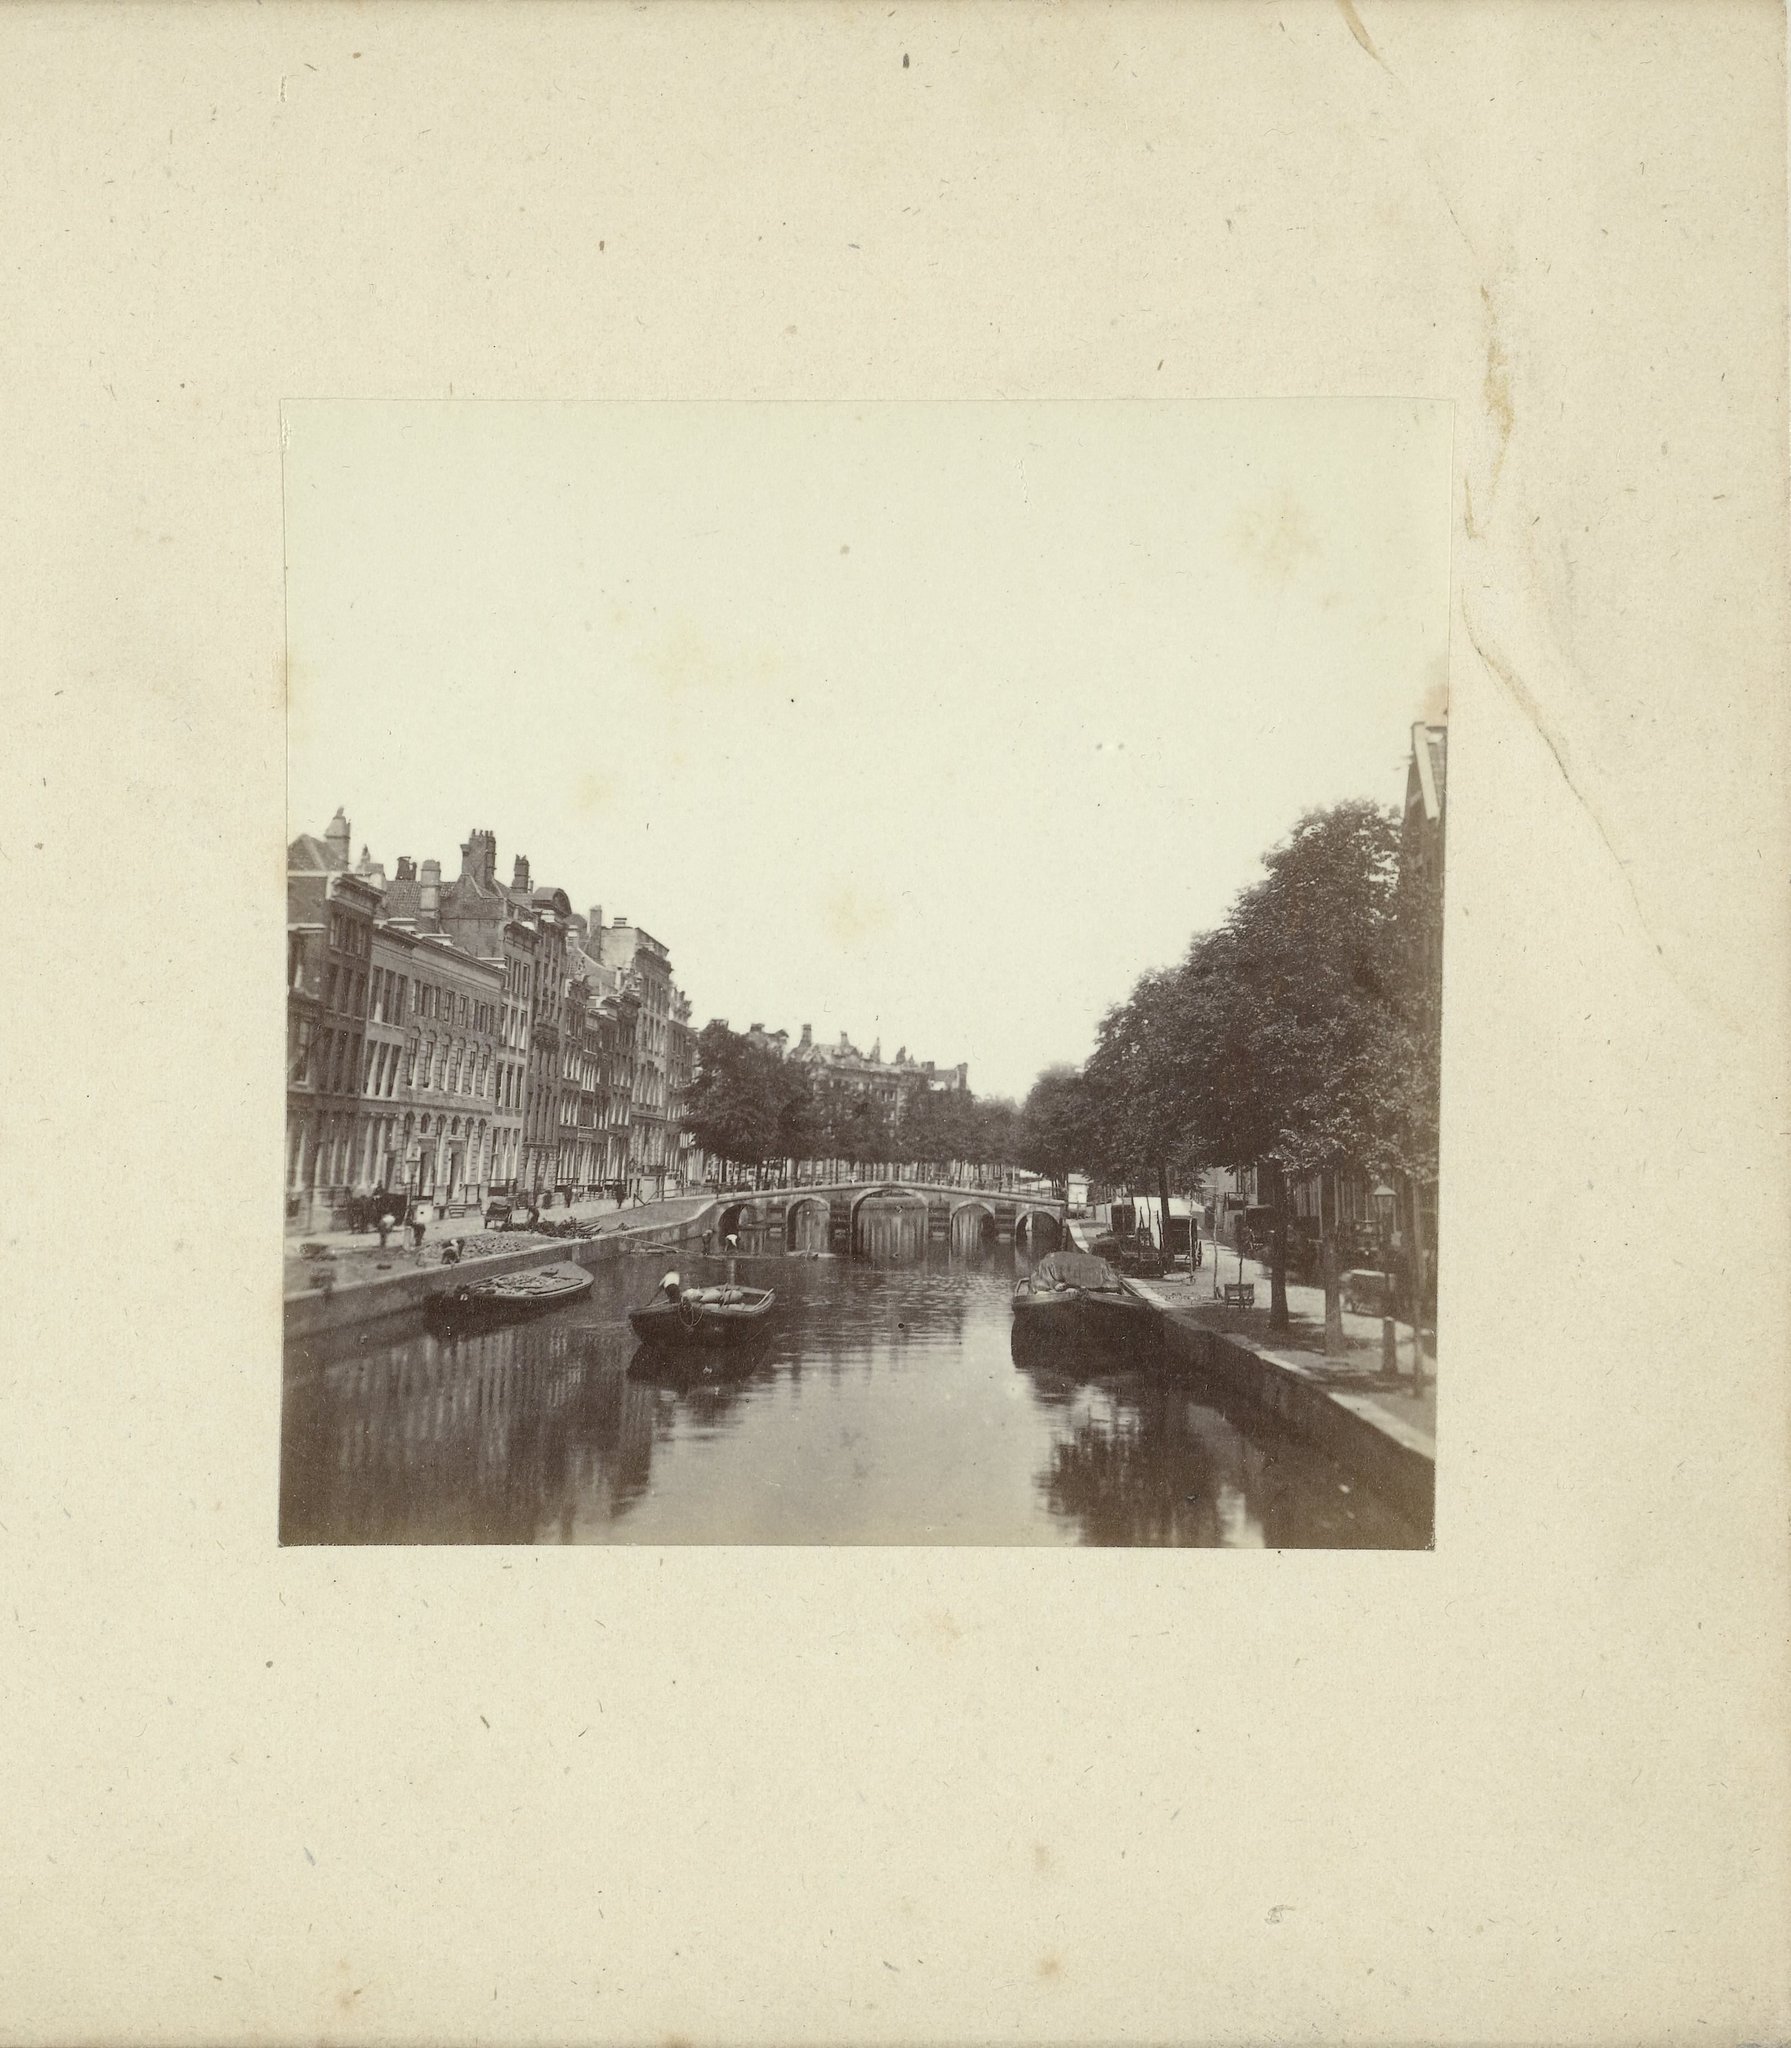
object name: photograph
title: De Heerengracht over de Warmoesgracht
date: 1860-1875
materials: cardboard, paper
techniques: albumen print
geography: amsterdam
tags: bridge in city across river, canal, etc.